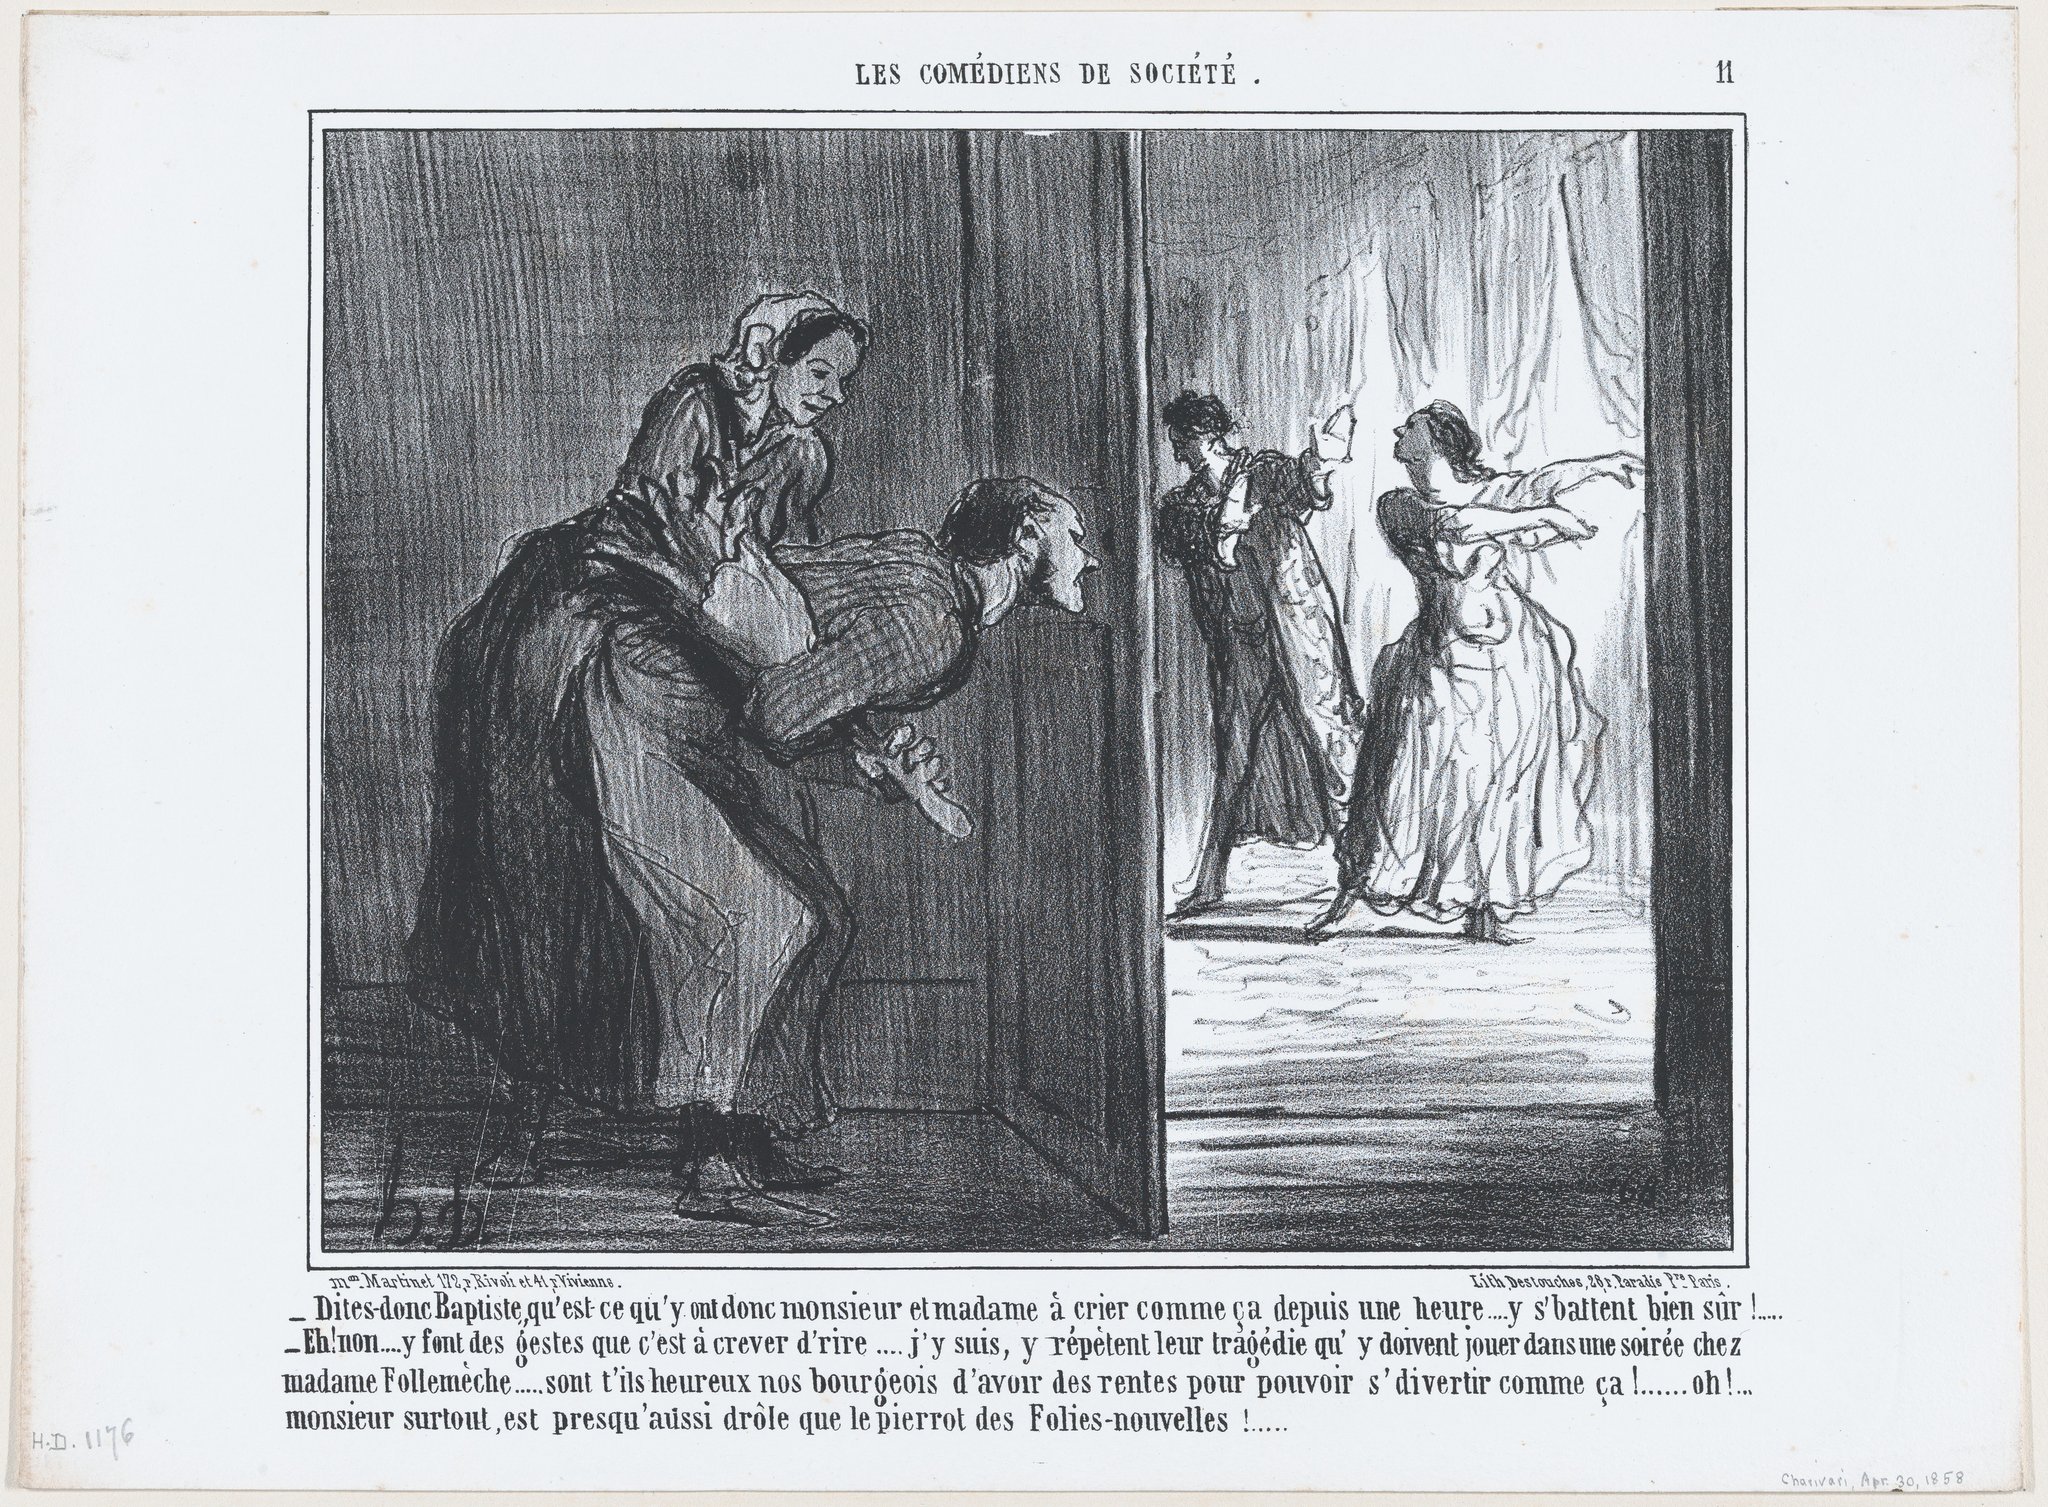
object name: print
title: Dites-donc Baptiste, qu'est-ce qu'y ont donc monsieur et madame à crier comme ça depuis une heure..., from Les Comédiens de Société, published in "Le Charivari"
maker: honoré daumier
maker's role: artist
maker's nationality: french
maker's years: 1808-1879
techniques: lithograph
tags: men,women